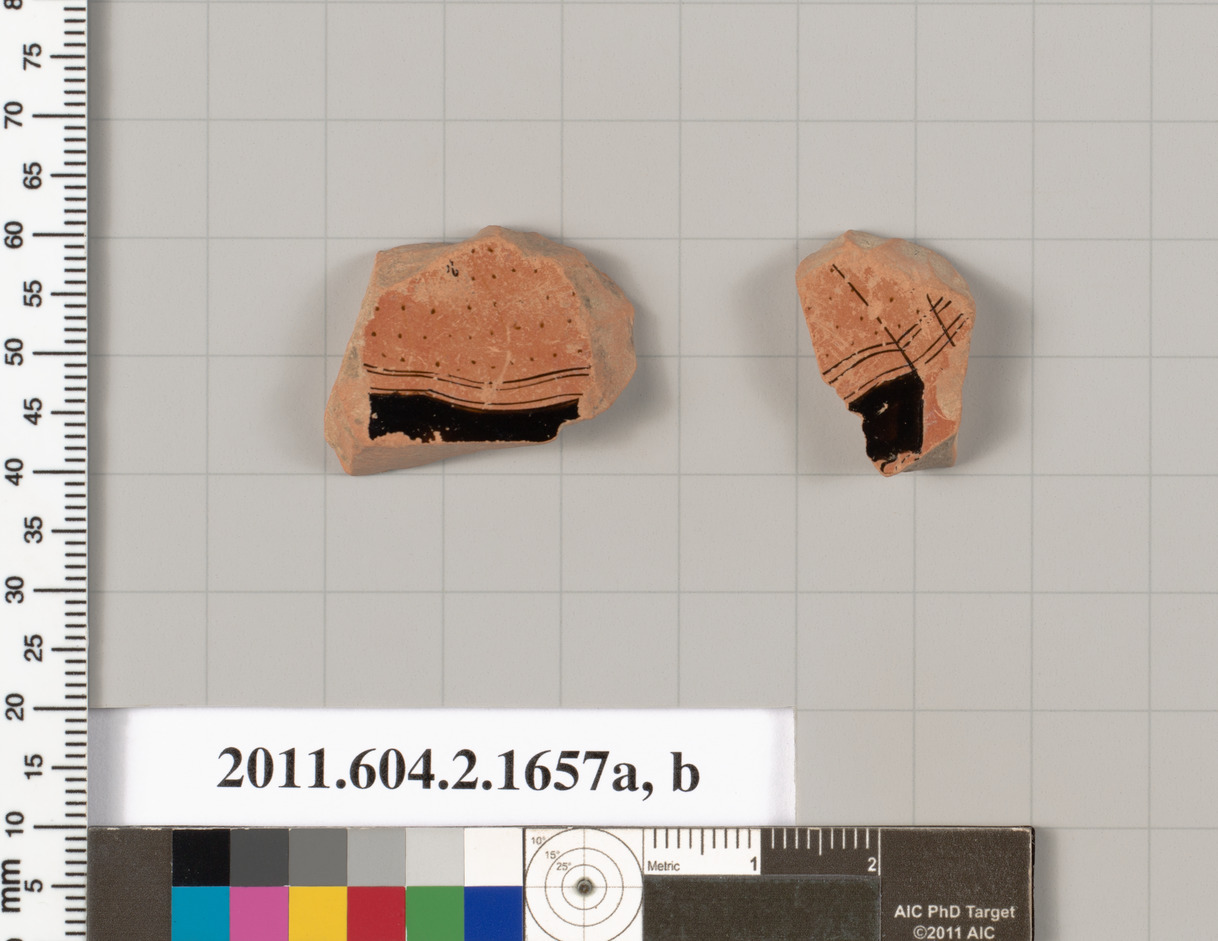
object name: skyphos fragment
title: Terracotta fragments of a skyphos (deep drinking cup)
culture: greek, attic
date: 470-460 BCE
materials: terracotta